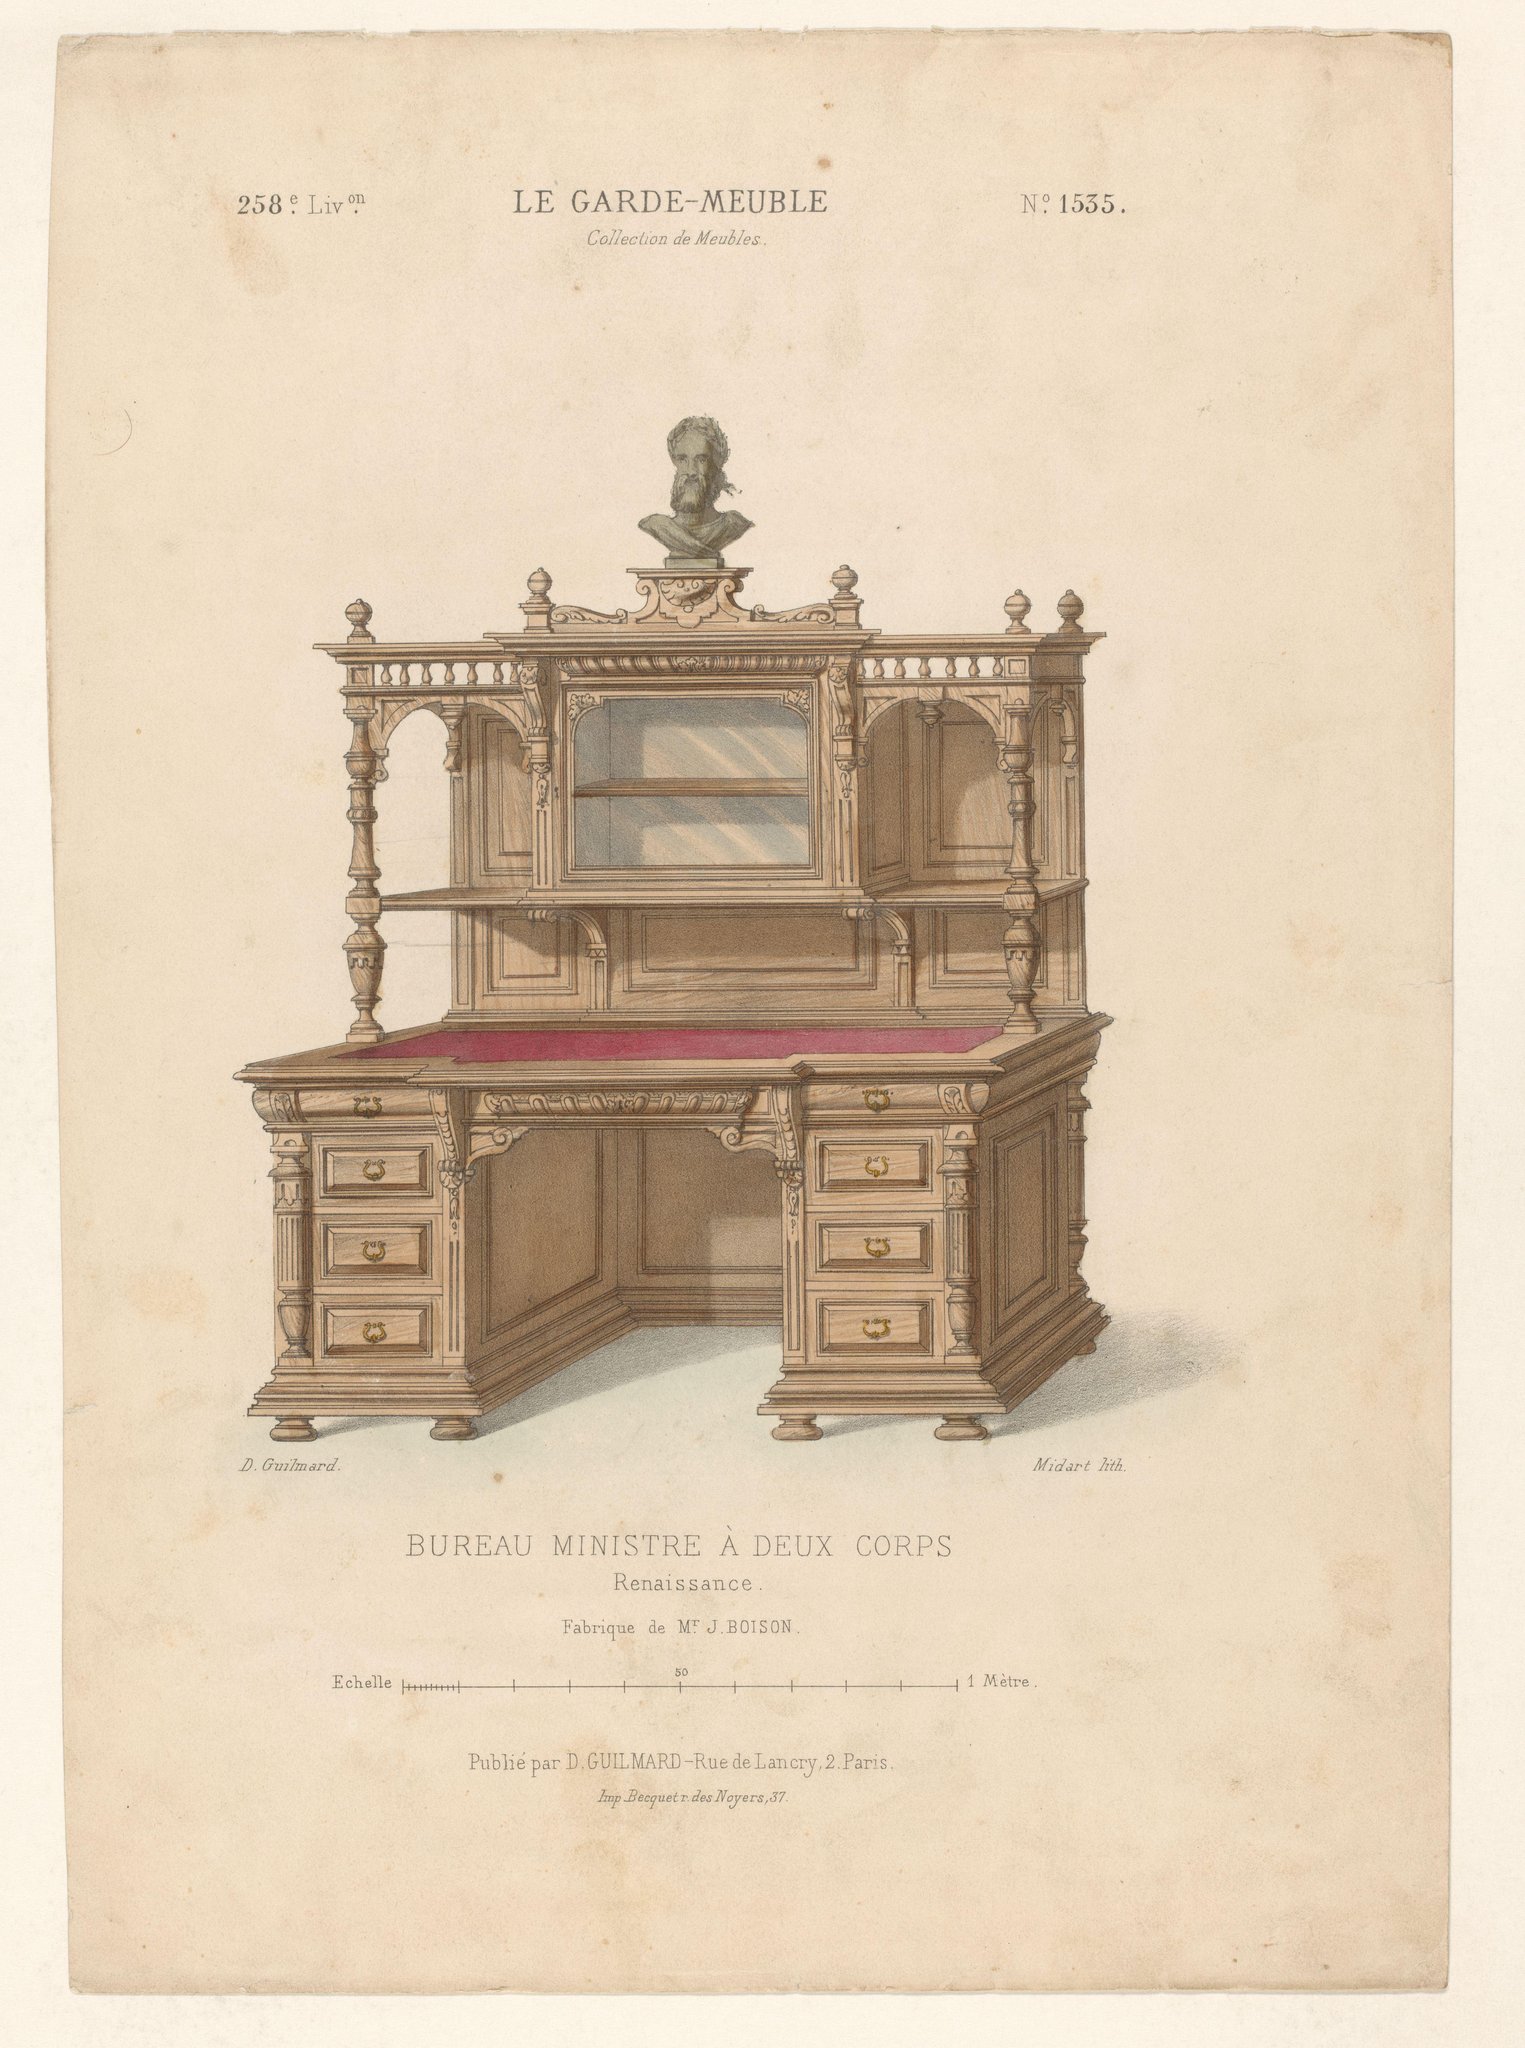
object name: print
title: Bureau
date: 1839-1885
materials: paper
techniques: hand coloring, lithograph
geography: paris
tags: writing-table, writing-desk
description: Ieder Livraison in de serie Le Garde-Meuble bevat negen platen: drie 'sièges' (zitmeubels), drie 'meubles' (diverse meubels zoals tafels en kasten) en drie 'tentures' (gordijnen en draperieën).